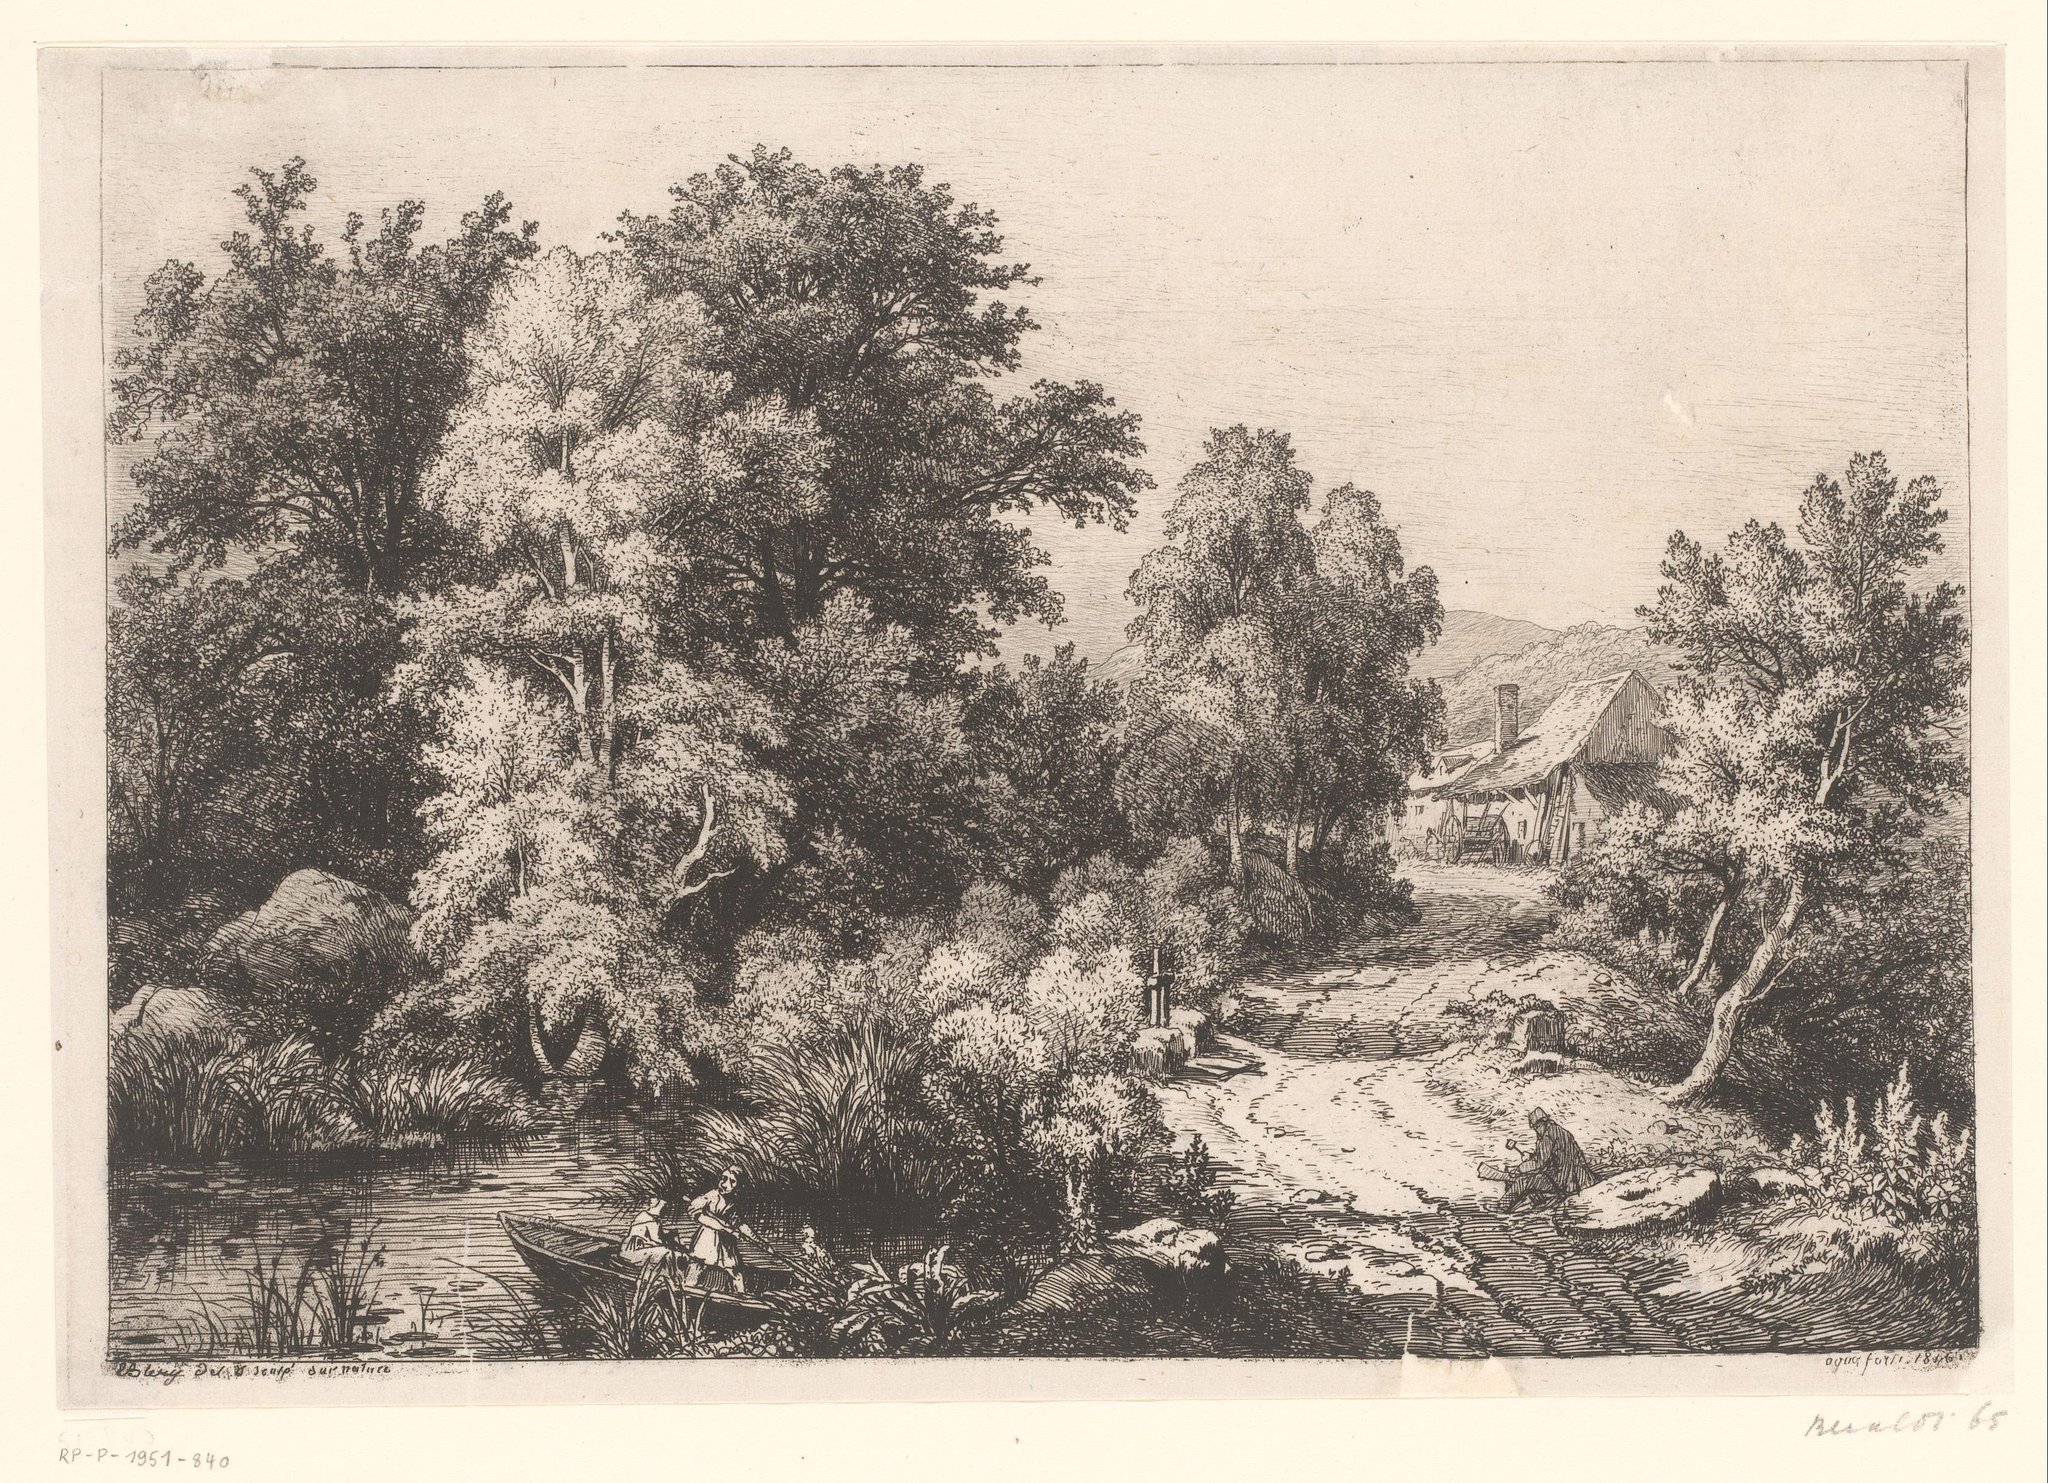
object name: print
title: Quatre paysages a l'eau forte par Eug. Bléry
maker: eugène bléry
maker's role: print maker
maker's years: 1805-1887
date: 1846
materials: paper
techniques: drypoint, etching, roulette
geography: france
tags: rural housing, e.g. country-house, villa, cottage, rowing-boat, canoe, etc., lake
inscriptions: date